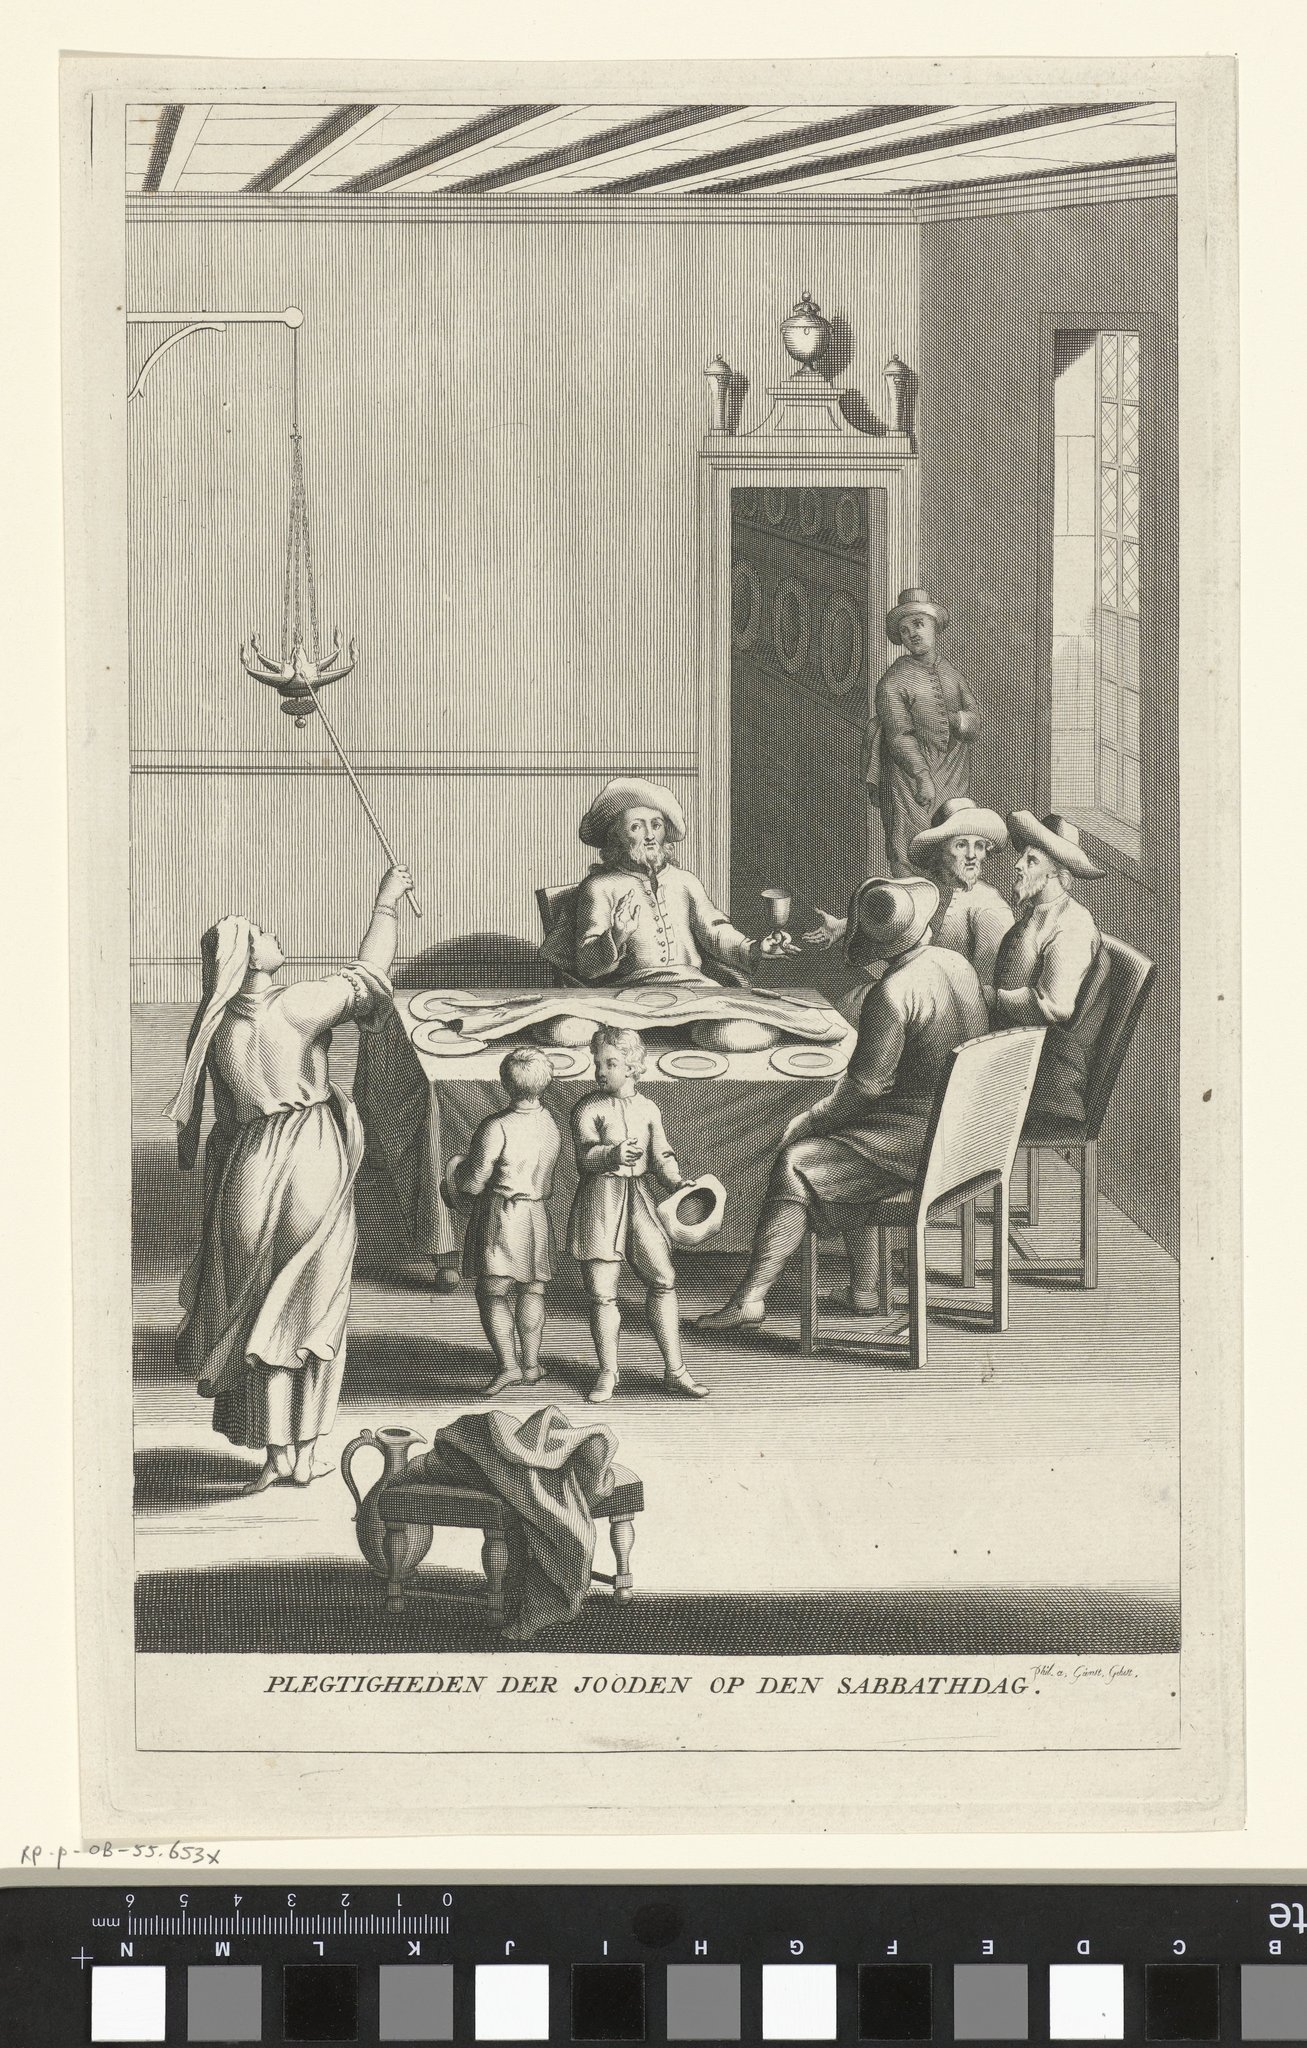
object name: print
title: Viering van de Sabbat bij een joods gezin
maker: philip van gunst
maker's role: print maker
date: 1685-1725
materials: paper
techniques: engraving, etching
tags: kindling and blessing of the sabbath lights by the mistress of the house, blessing the bread and the wine ~ sabbath at home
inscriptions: collector's mark: Lugt 240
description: Ook gebruikt als boekillustratie voor Calmet, Augustin. Het algemeen groot historisch, oordeelkundig, chronologisch, geografisch en letterlyk naam- en woord-boek van den gantschen H. Bybel. Amsterdam: R. en J. Wetstein en W. Smith, 1725-1727.